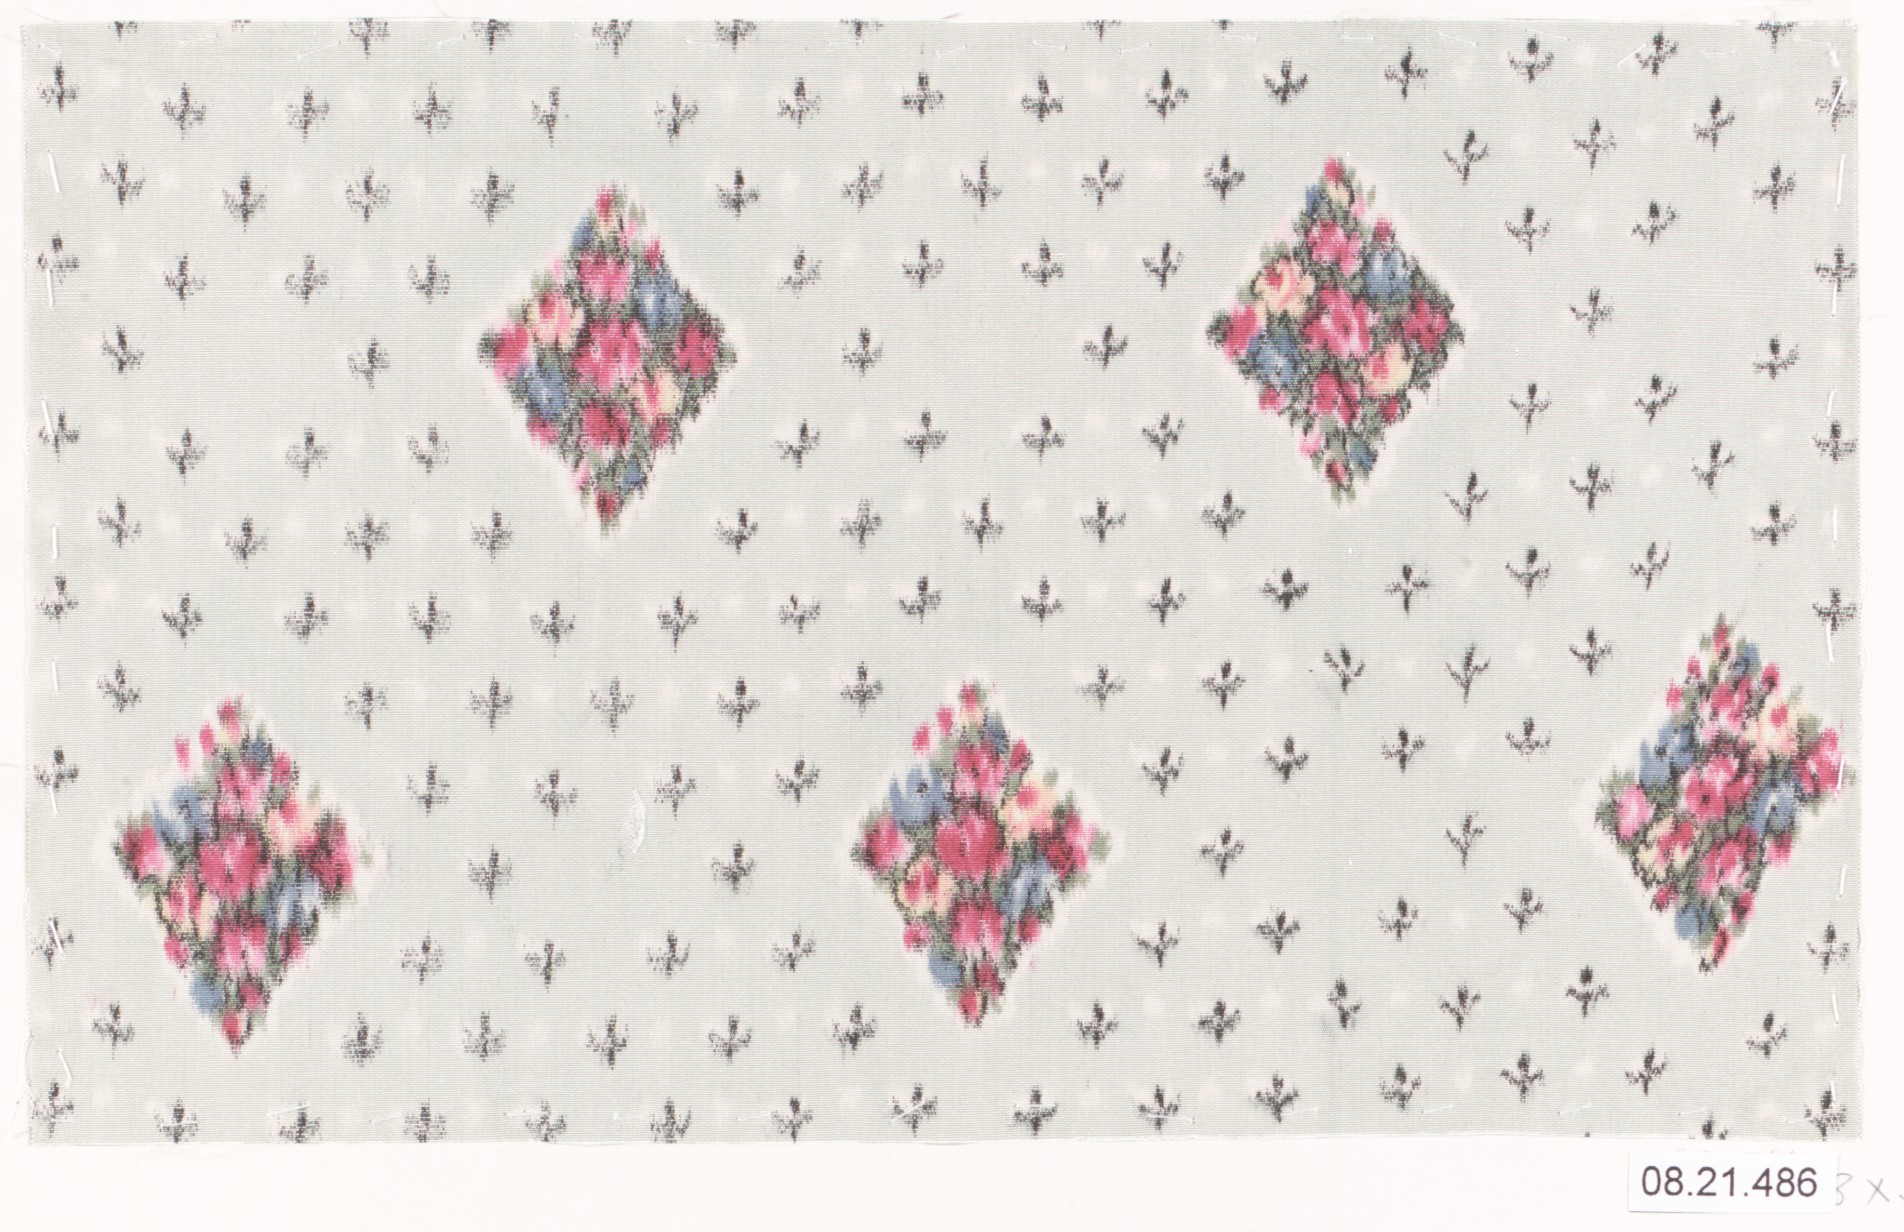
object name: textile sample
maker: Anonymous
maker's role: designer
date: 1900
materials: silk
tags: flowers